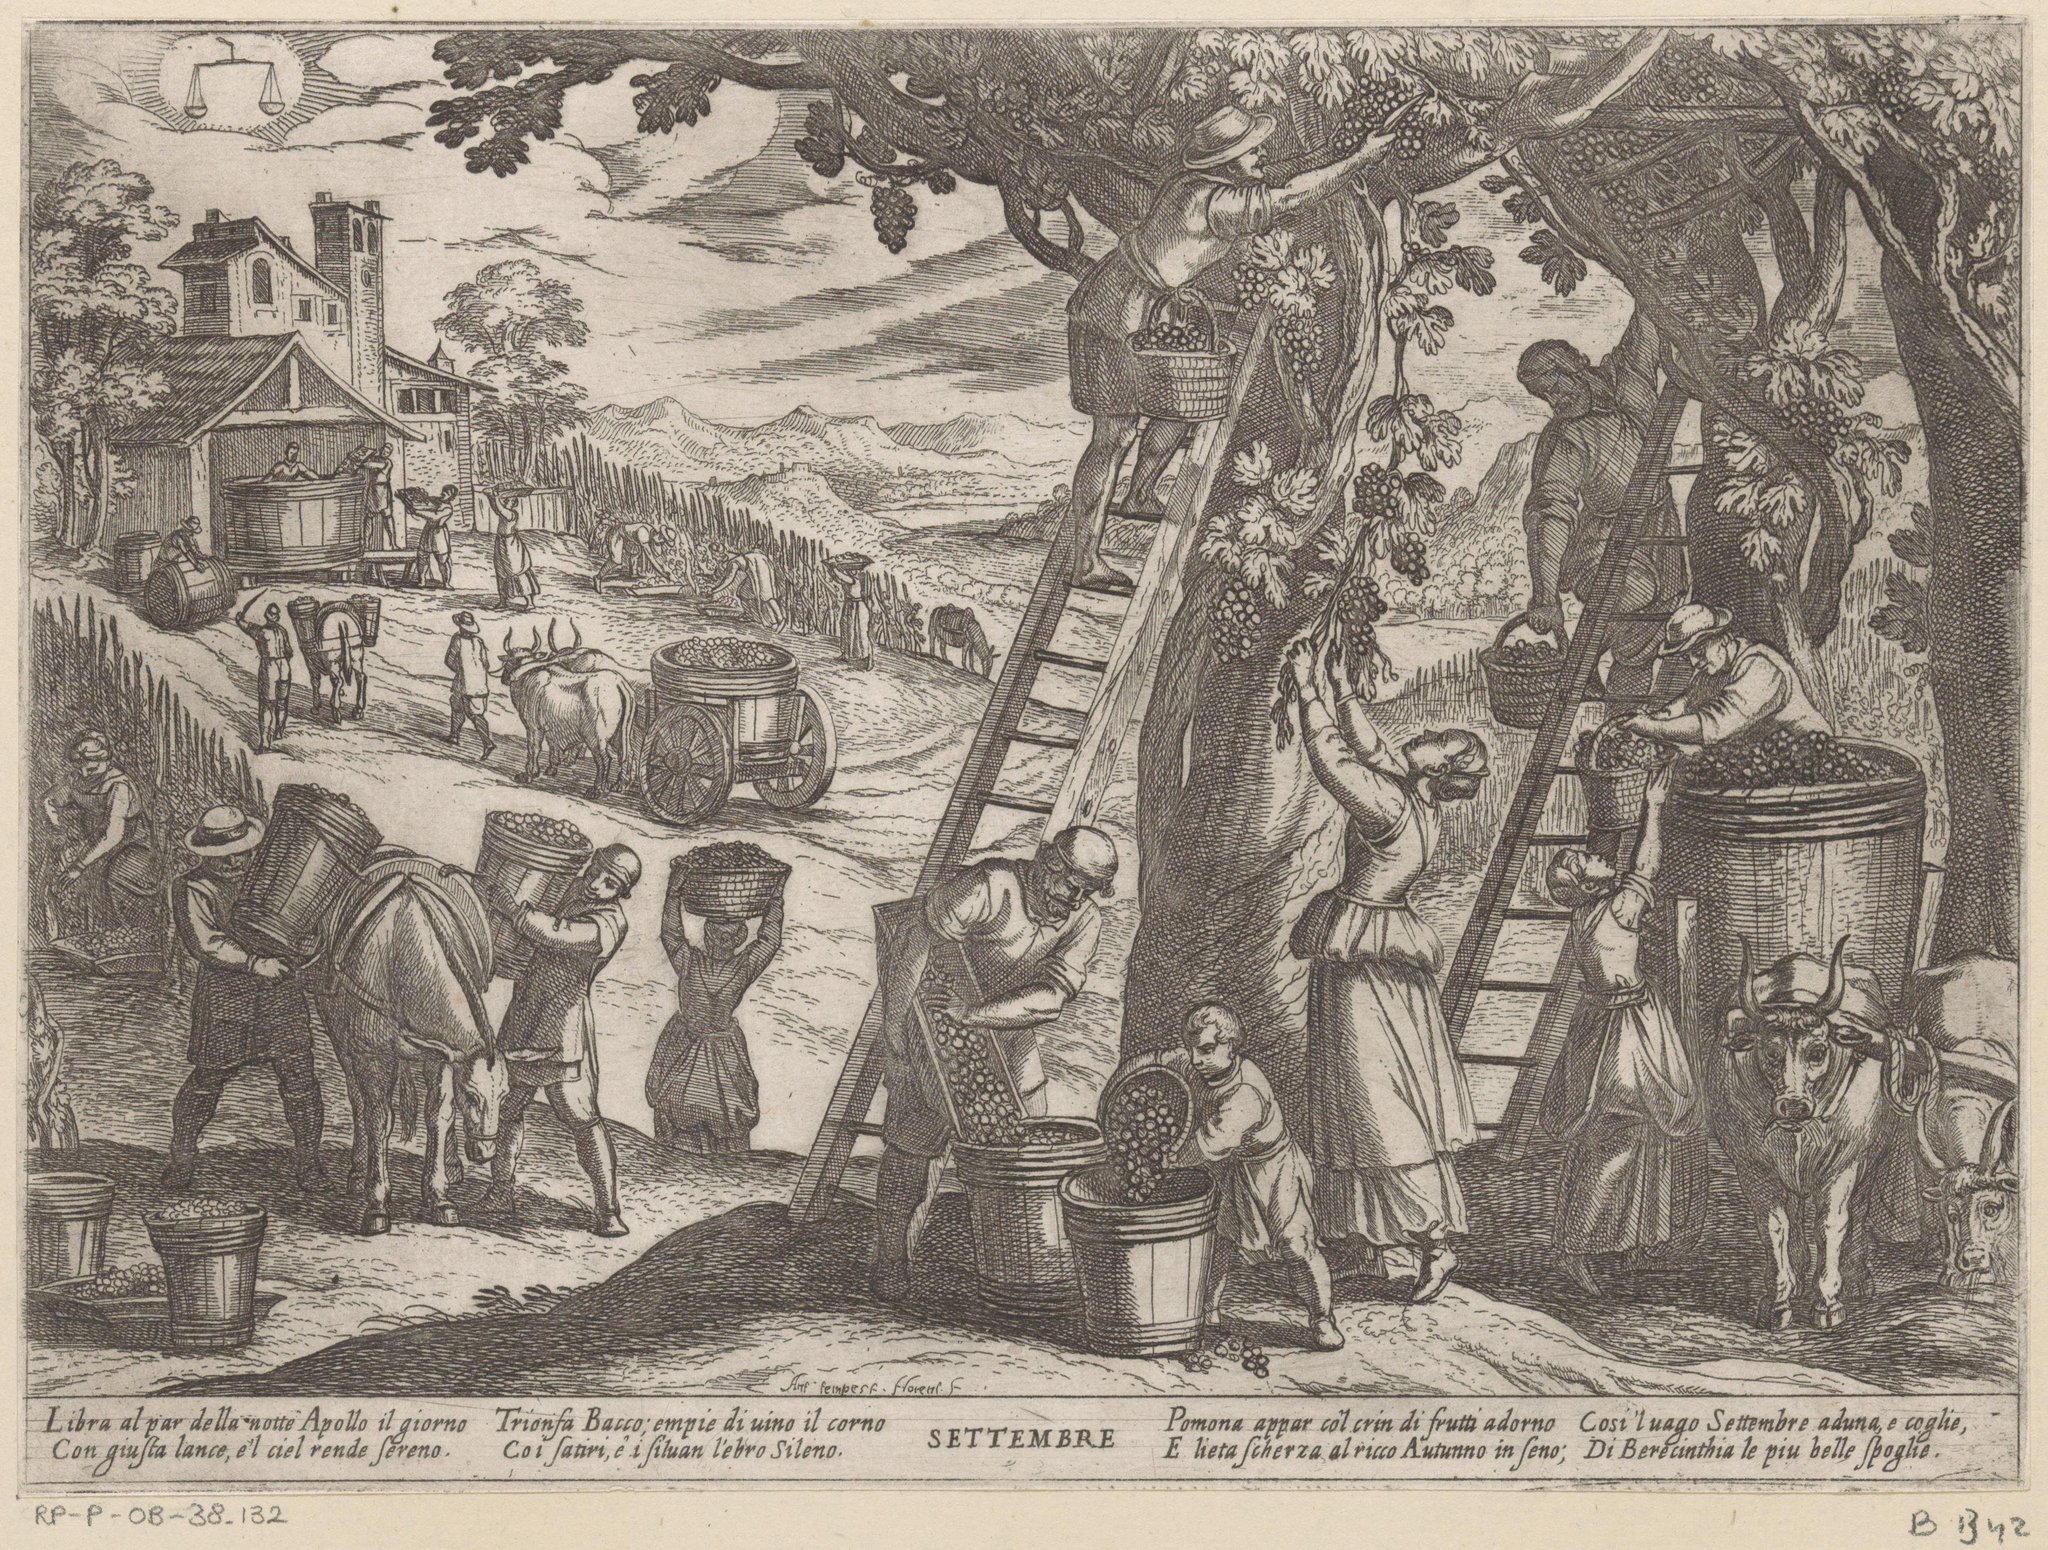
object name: print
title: De twaalf maanden (deel 1)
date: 1599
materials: paper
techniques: etching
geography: italy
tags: the twelve months represented by scenes showing human activities, usually in a landscape; so-called 'labours of the months', libra (zodiacal sign of september), vintage, grape harvest, transport of grapes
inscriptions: collector's mark: Lugt 240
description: Verbeelding van menselijke activiteit in de maand september. Landschap met boeren die wijn oogsten. Midden boven het symbool voor het sterrenbeeld weegschaal. Italiaans vers en titel in ondermarge.